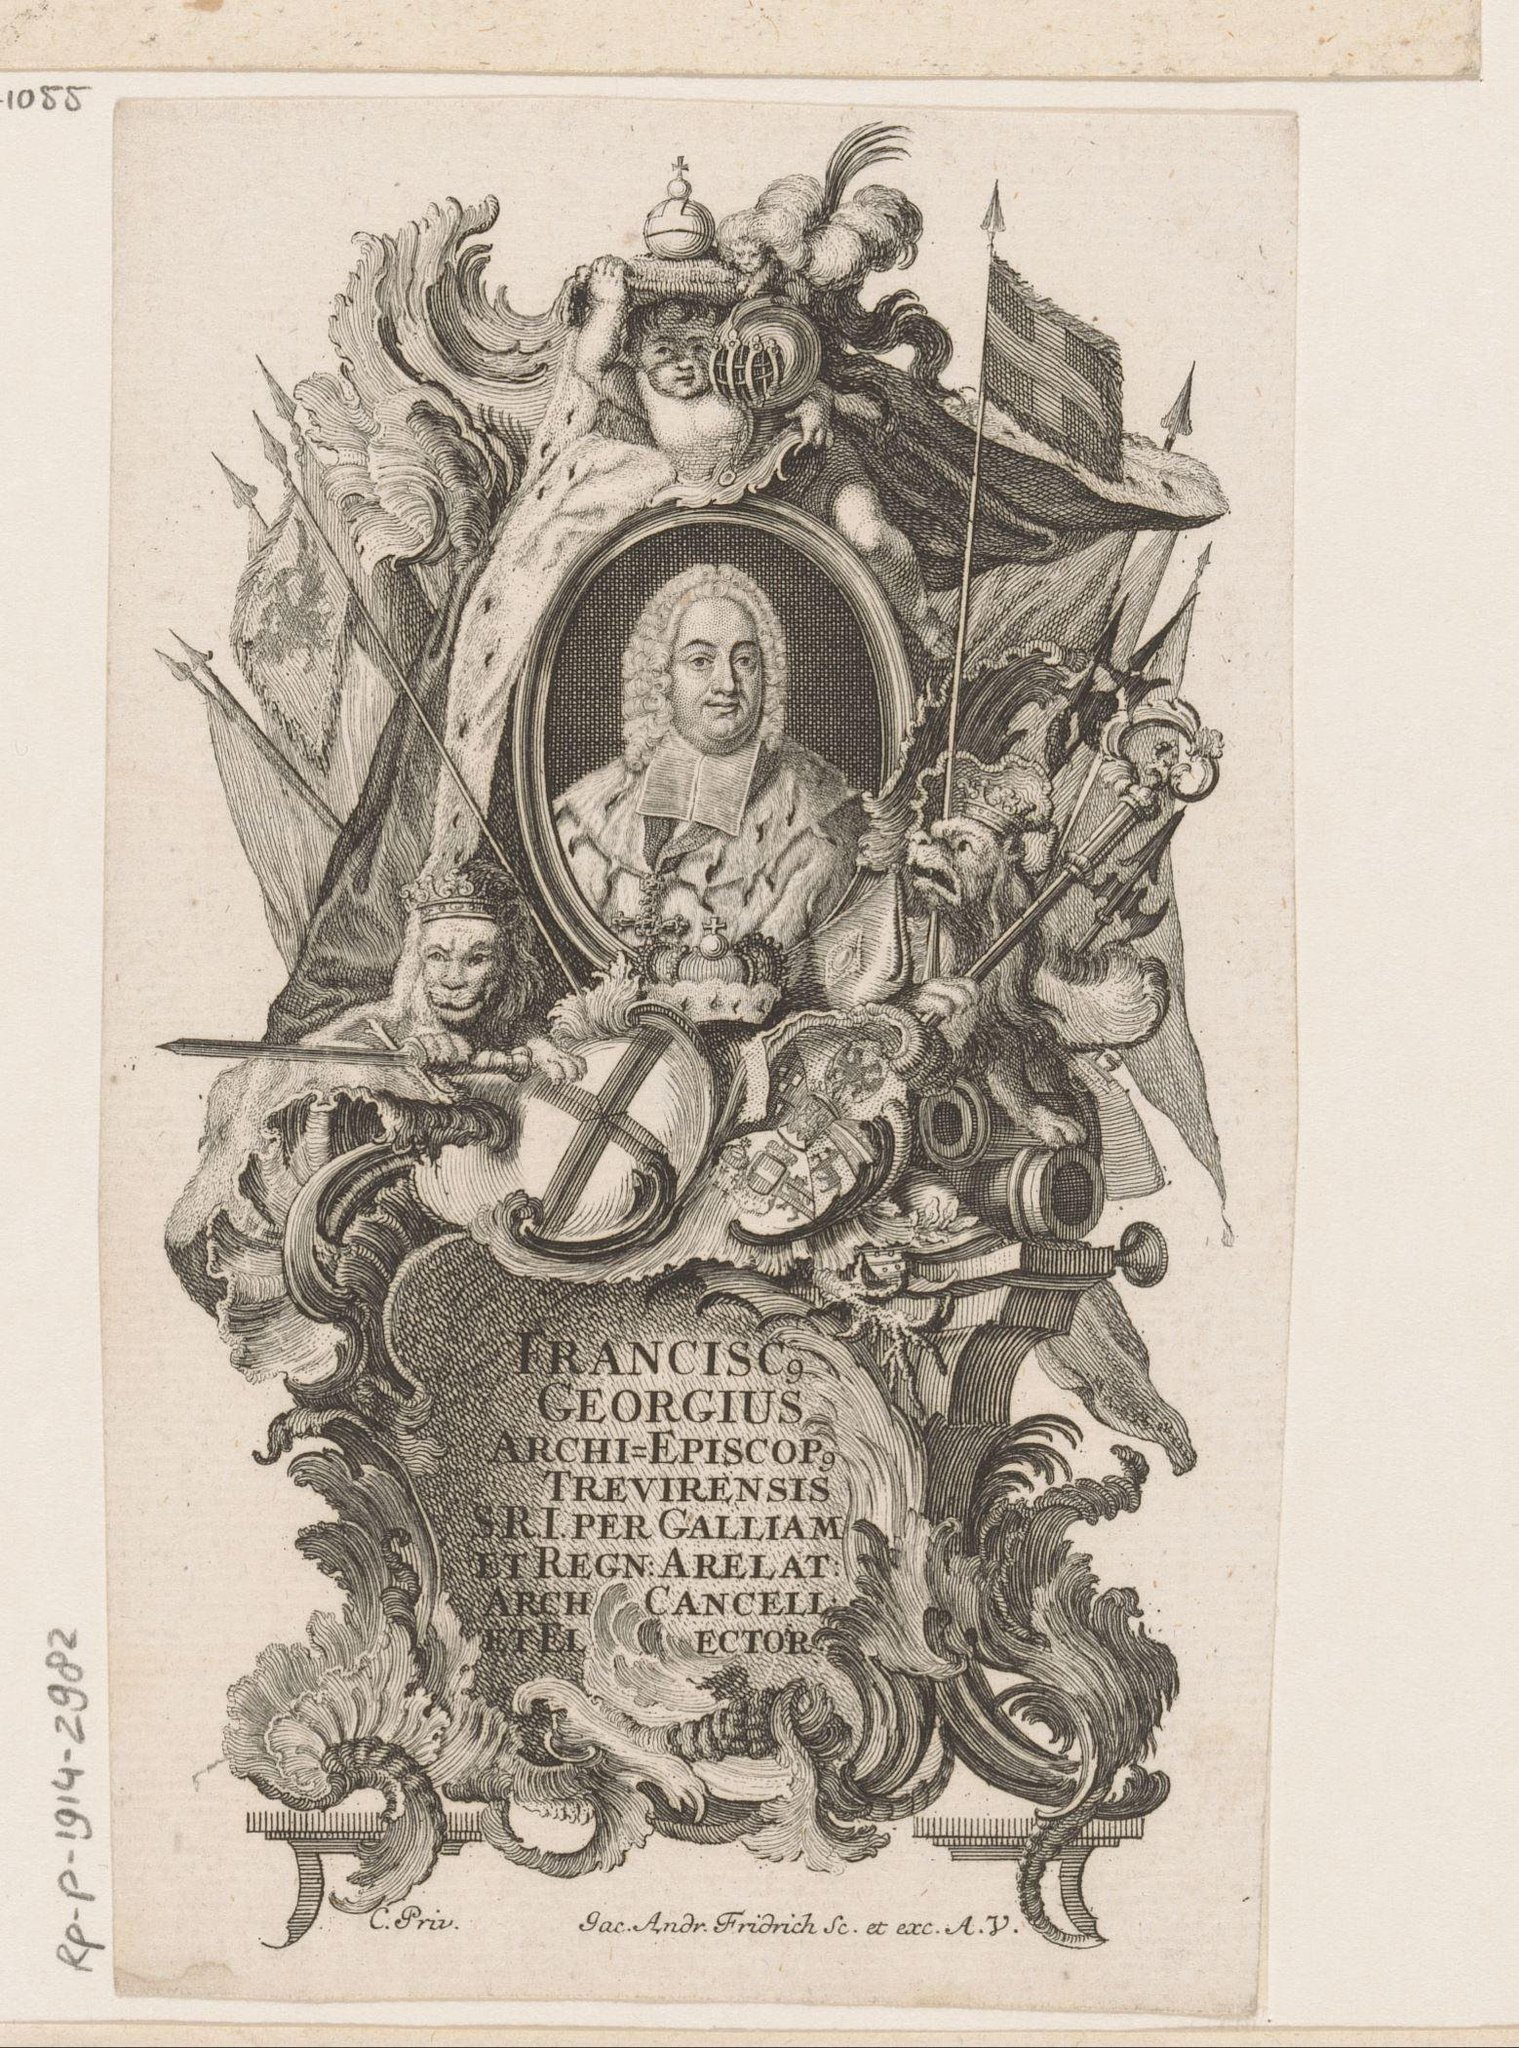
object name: print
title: Portret van Franz Georg von Schönberg in allegorische omlijsting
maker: Anonymous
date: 1729-1756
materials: paper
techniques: engraving, etching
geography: holy roman empire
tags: rocaille ornament, insignia of bishop, e.g. mitre, crozier, historical persons, armorial bearing, heraldry, insignia and symbols of sovereignty (crown, diadem, sceptre, orb, seal, standard, cloak, pectoral)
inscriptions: collector's mark: Lugt 2228